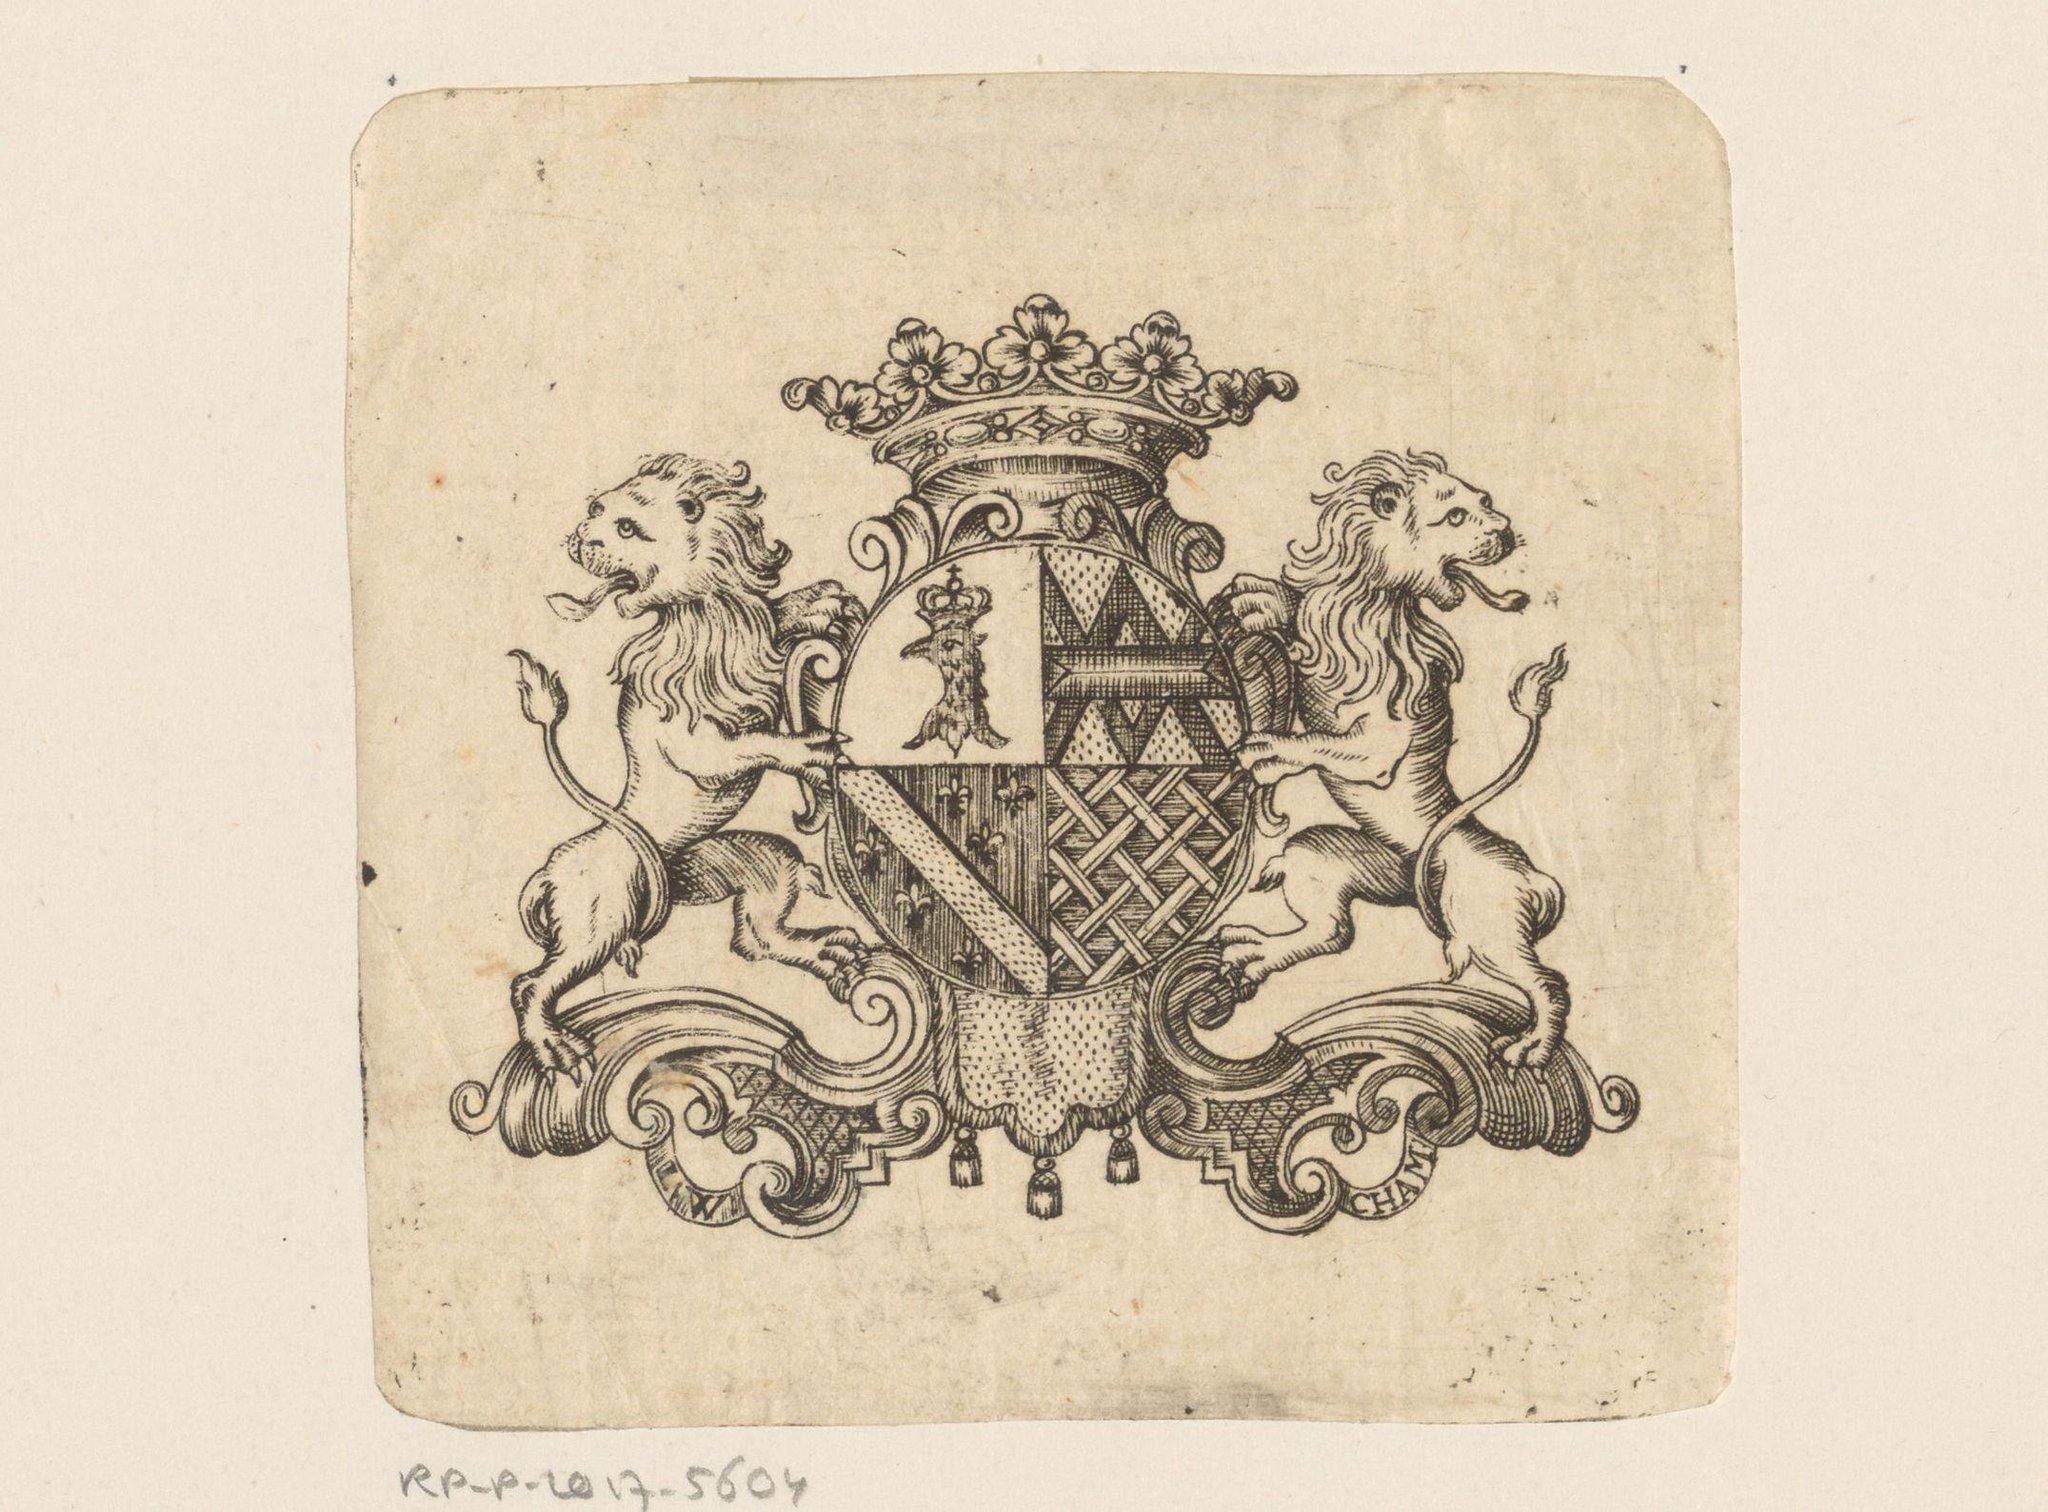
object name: bookplate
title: Ex libris van L:W: Cham:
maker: Anonymous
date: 1700-1799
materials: paper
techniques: etching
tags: beasts of prey, predatory animals: lion, armorial bearing, heraldry